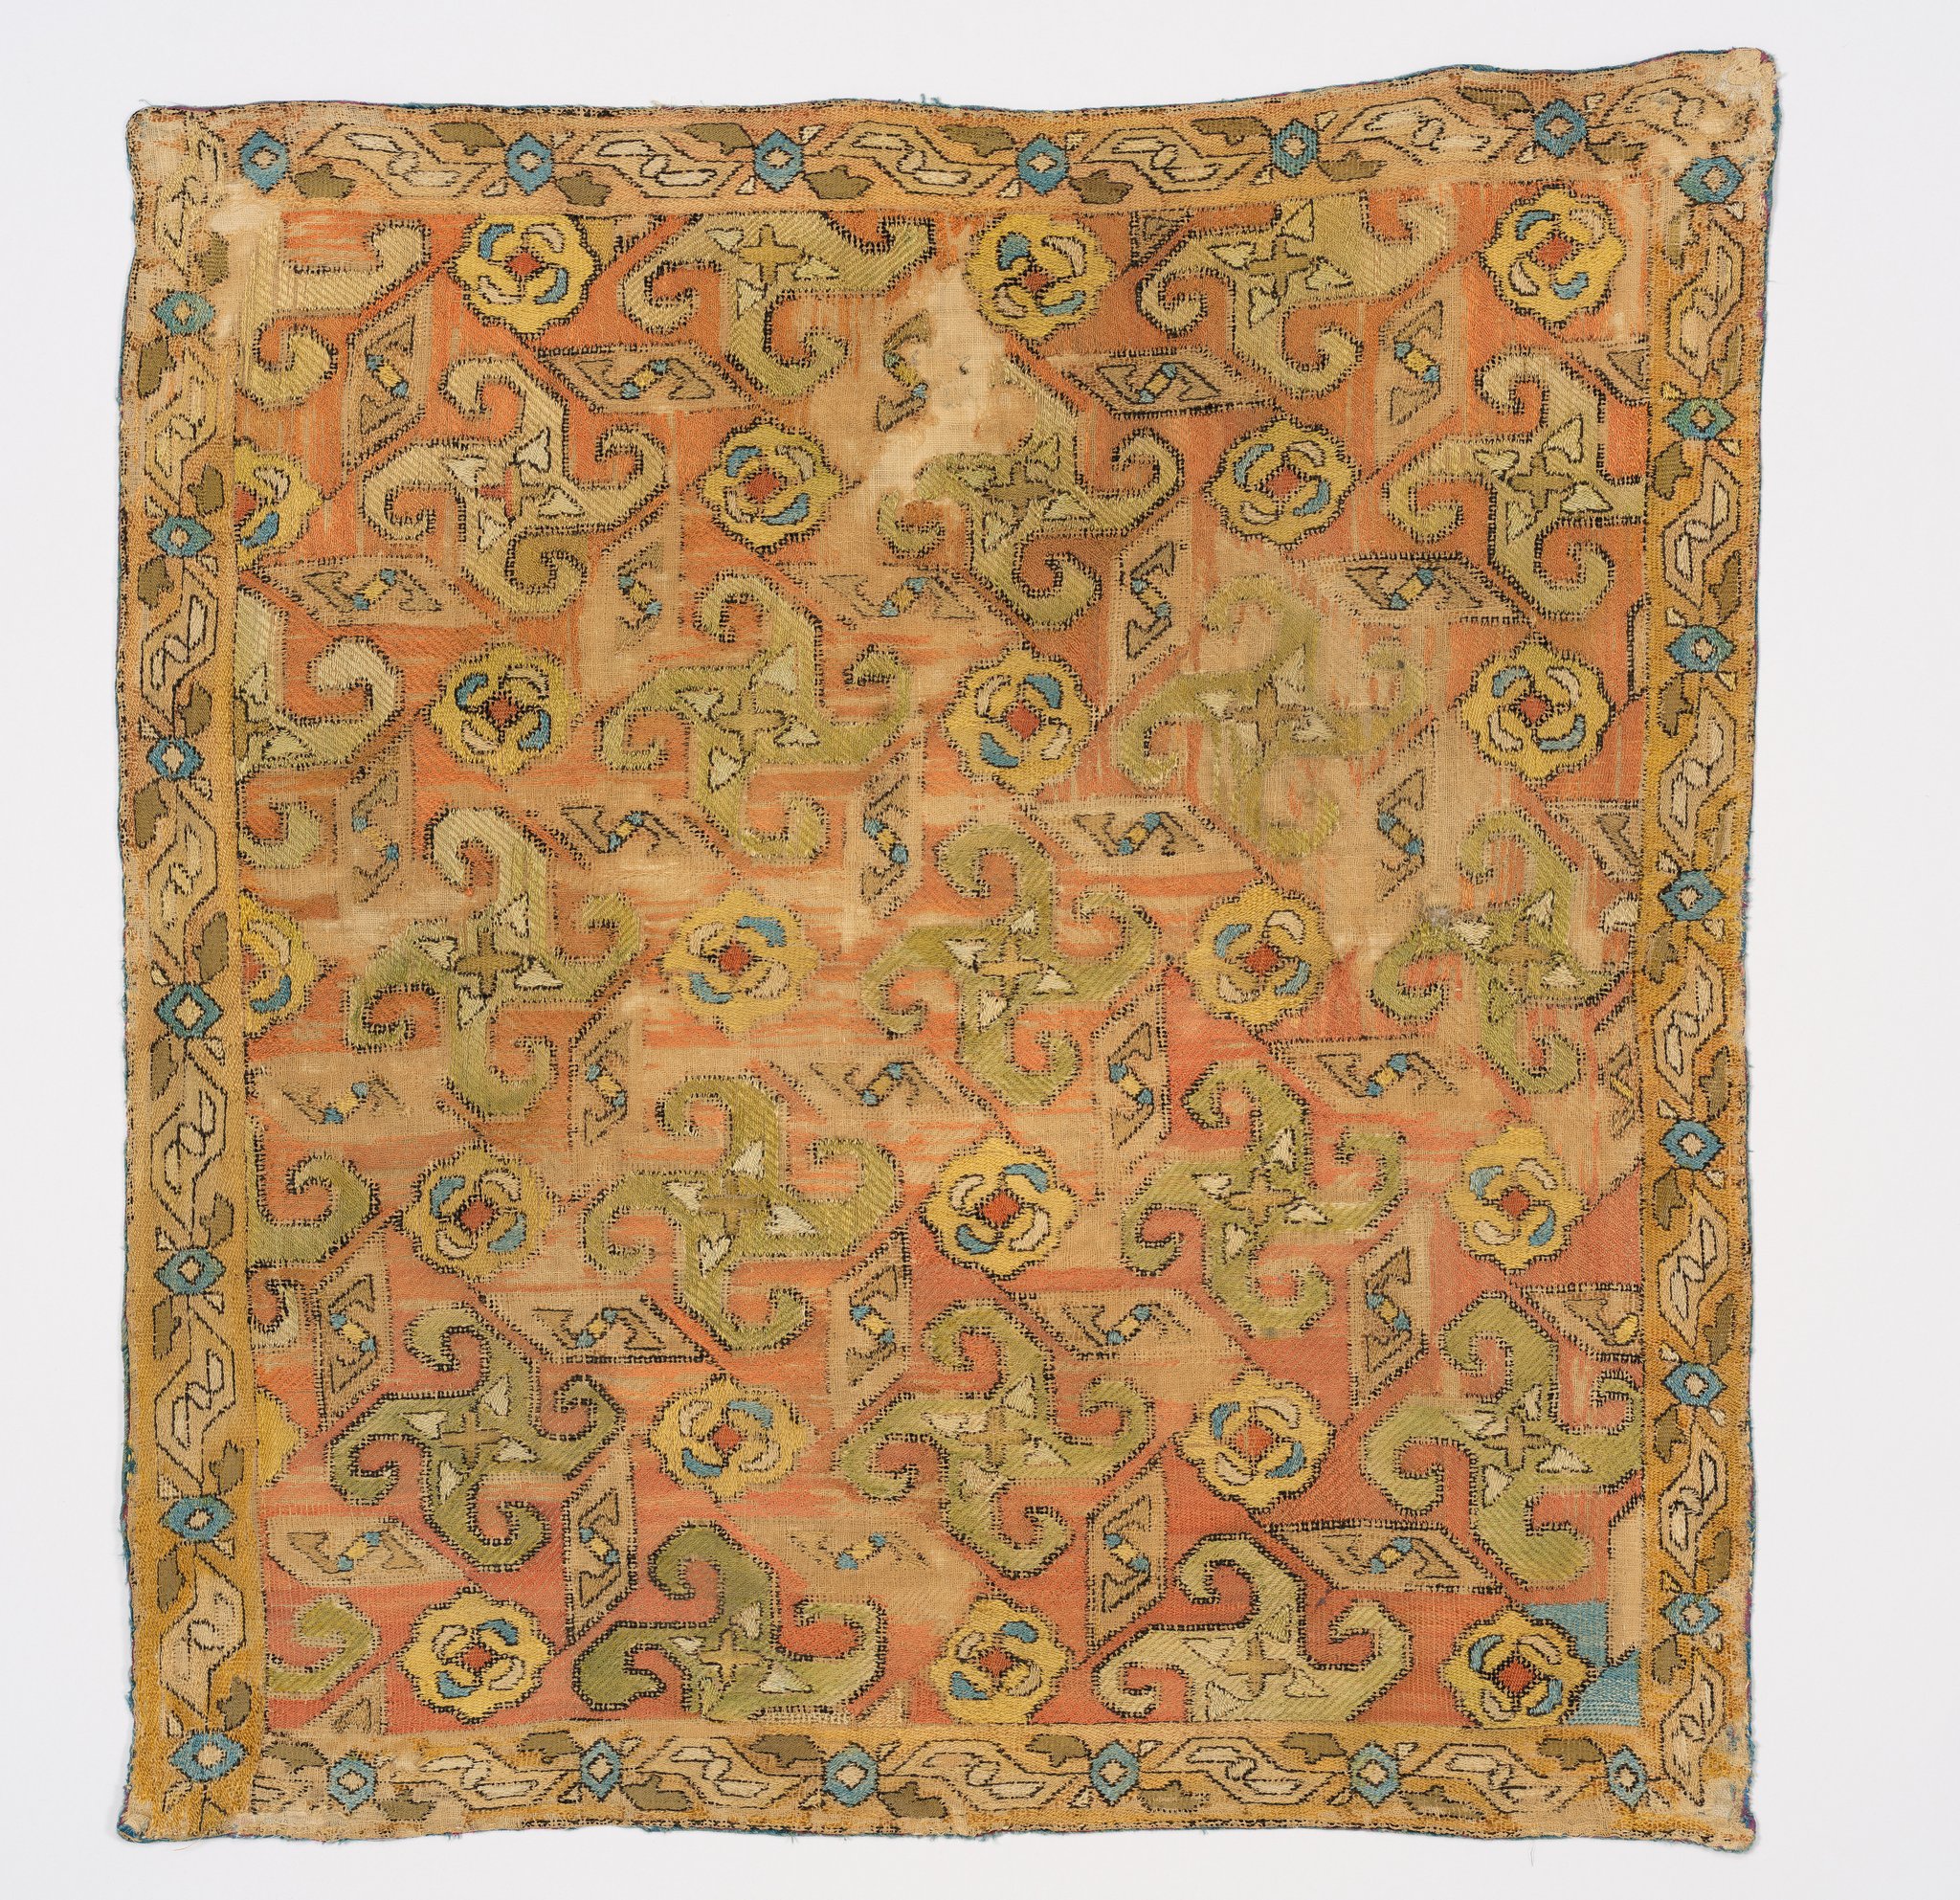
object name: cover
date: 1701-1800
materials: linen, silk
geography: caucasus